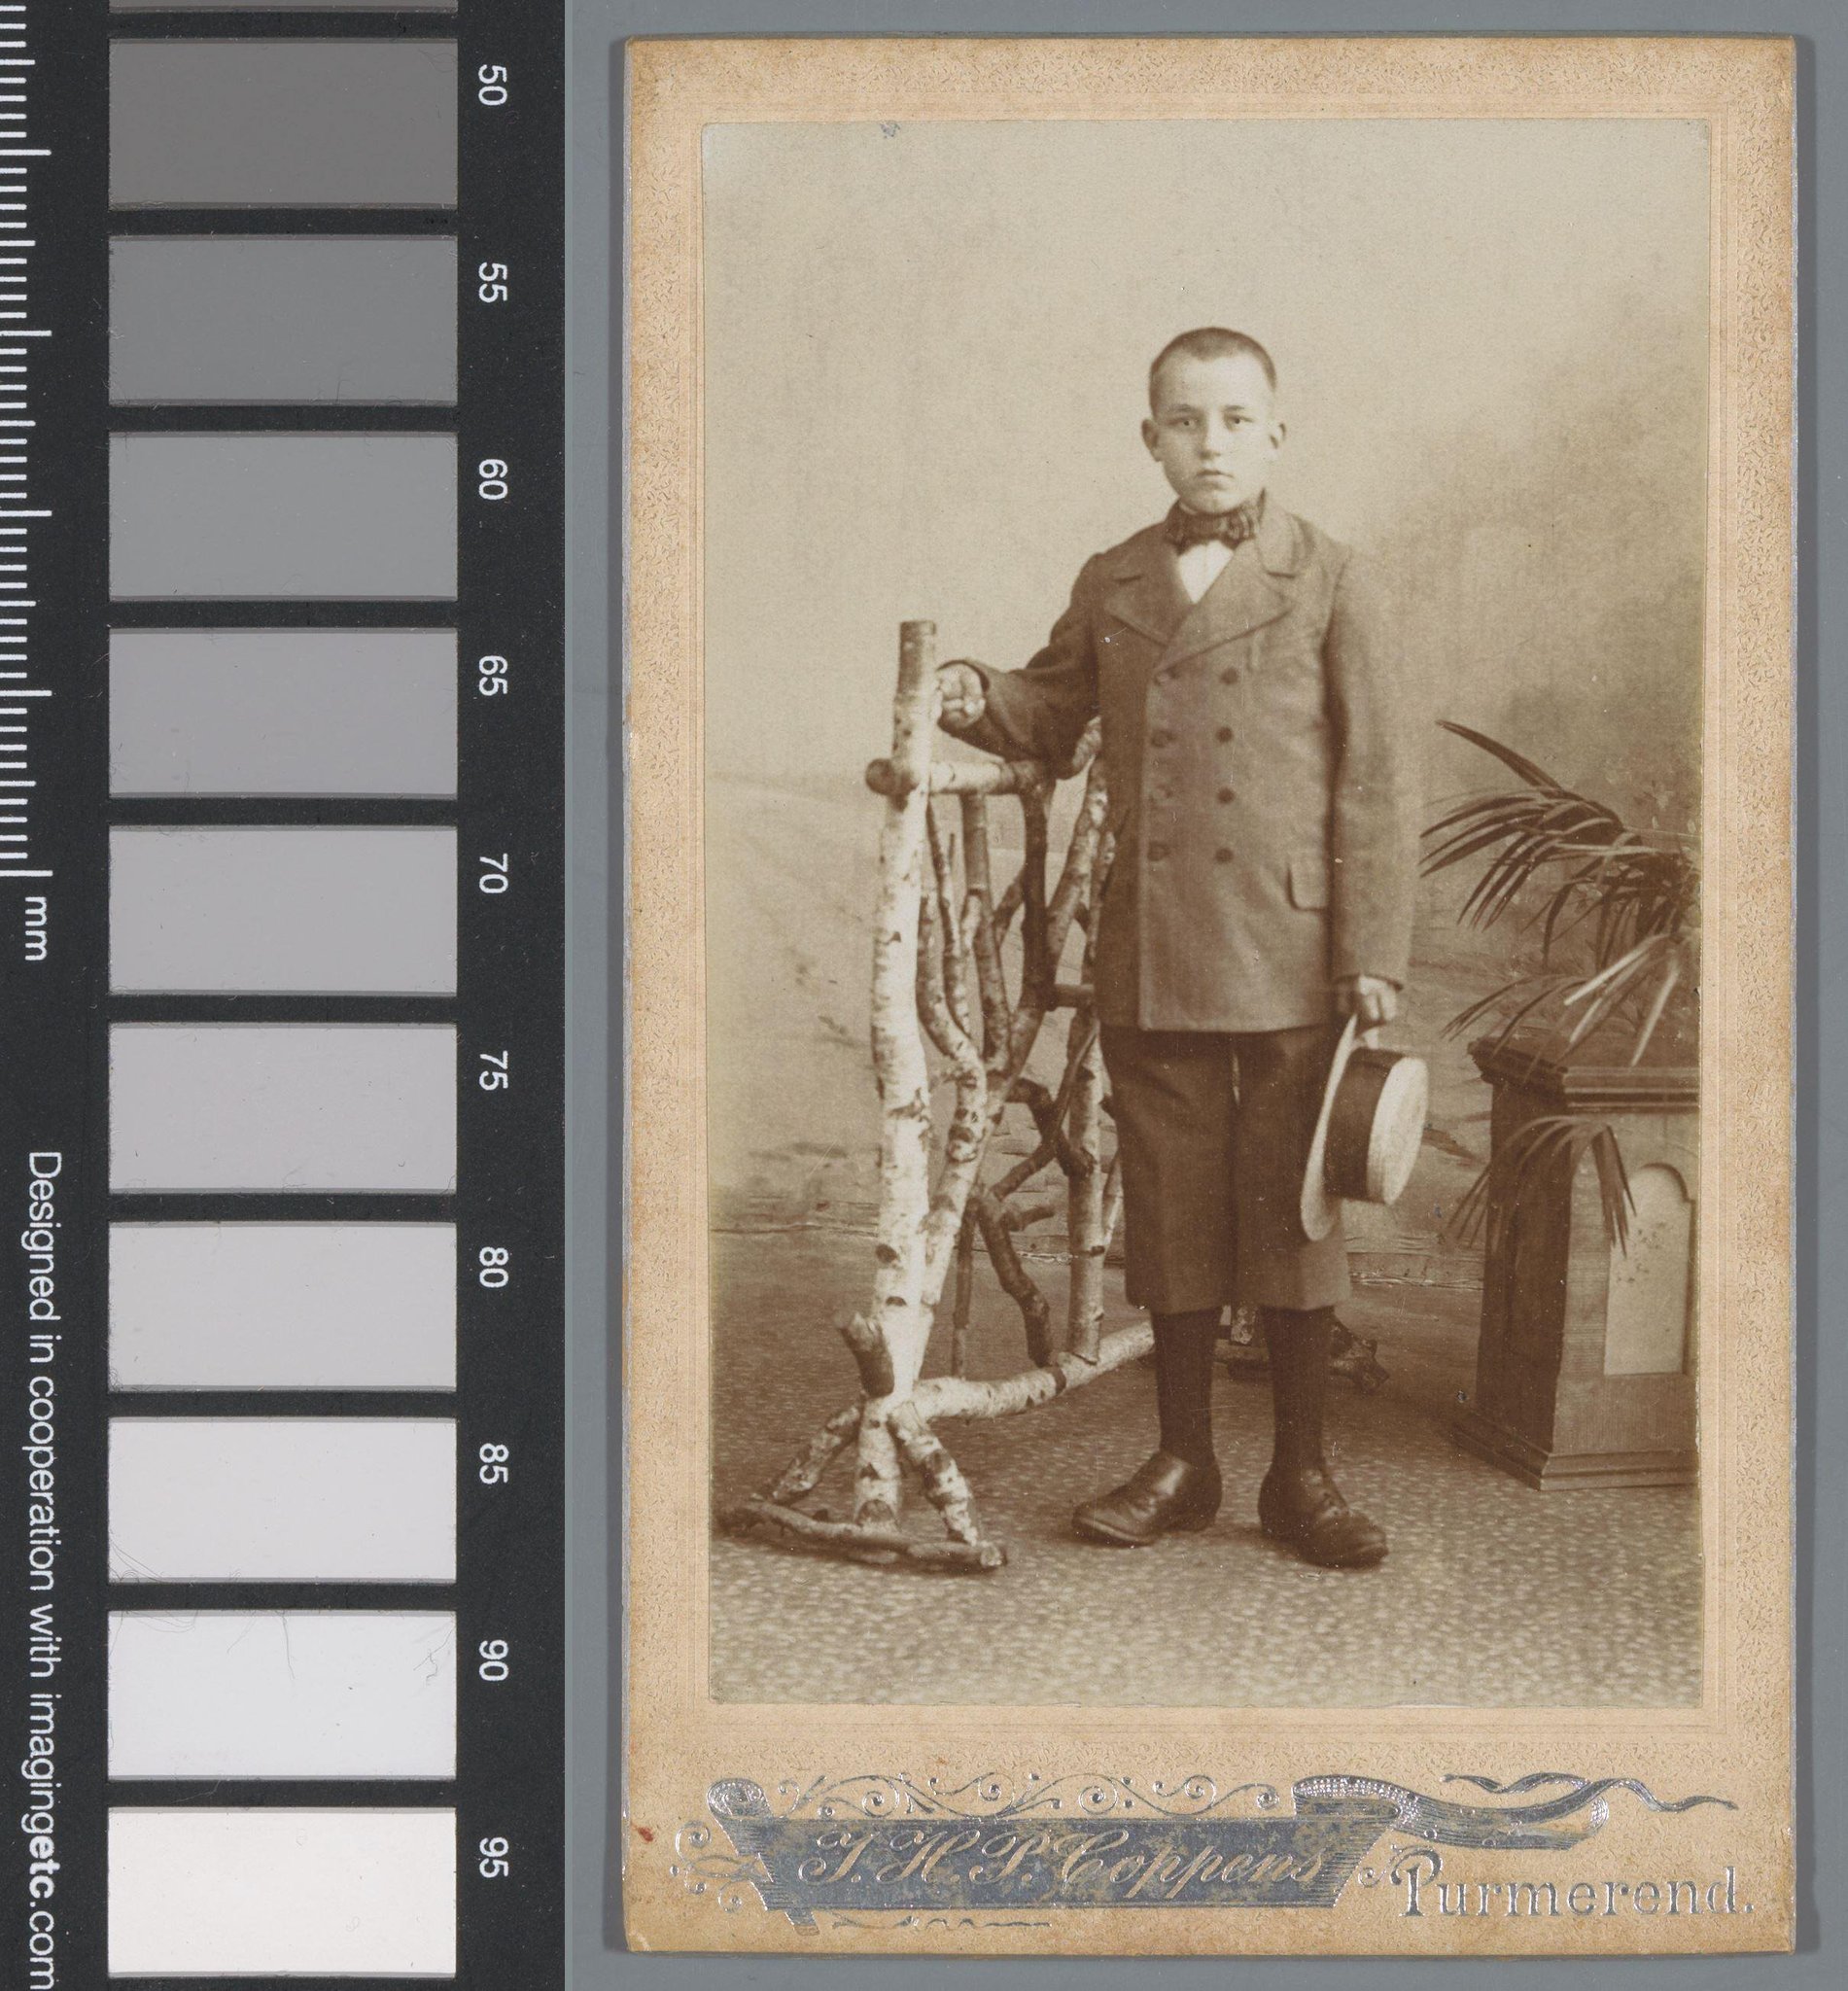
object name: carte de visite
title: Portret van Dirk Pronk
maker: josephus hendrikus petrus coppens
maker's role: fotograaf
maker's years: 1864-1941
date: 1889-1925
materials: cardboard, paper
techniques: albumen print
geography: purmerend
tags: boy (child between toddler and youth), historical persons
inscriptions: inscription: ‘Negatieven voor nabestelling bewaard.’